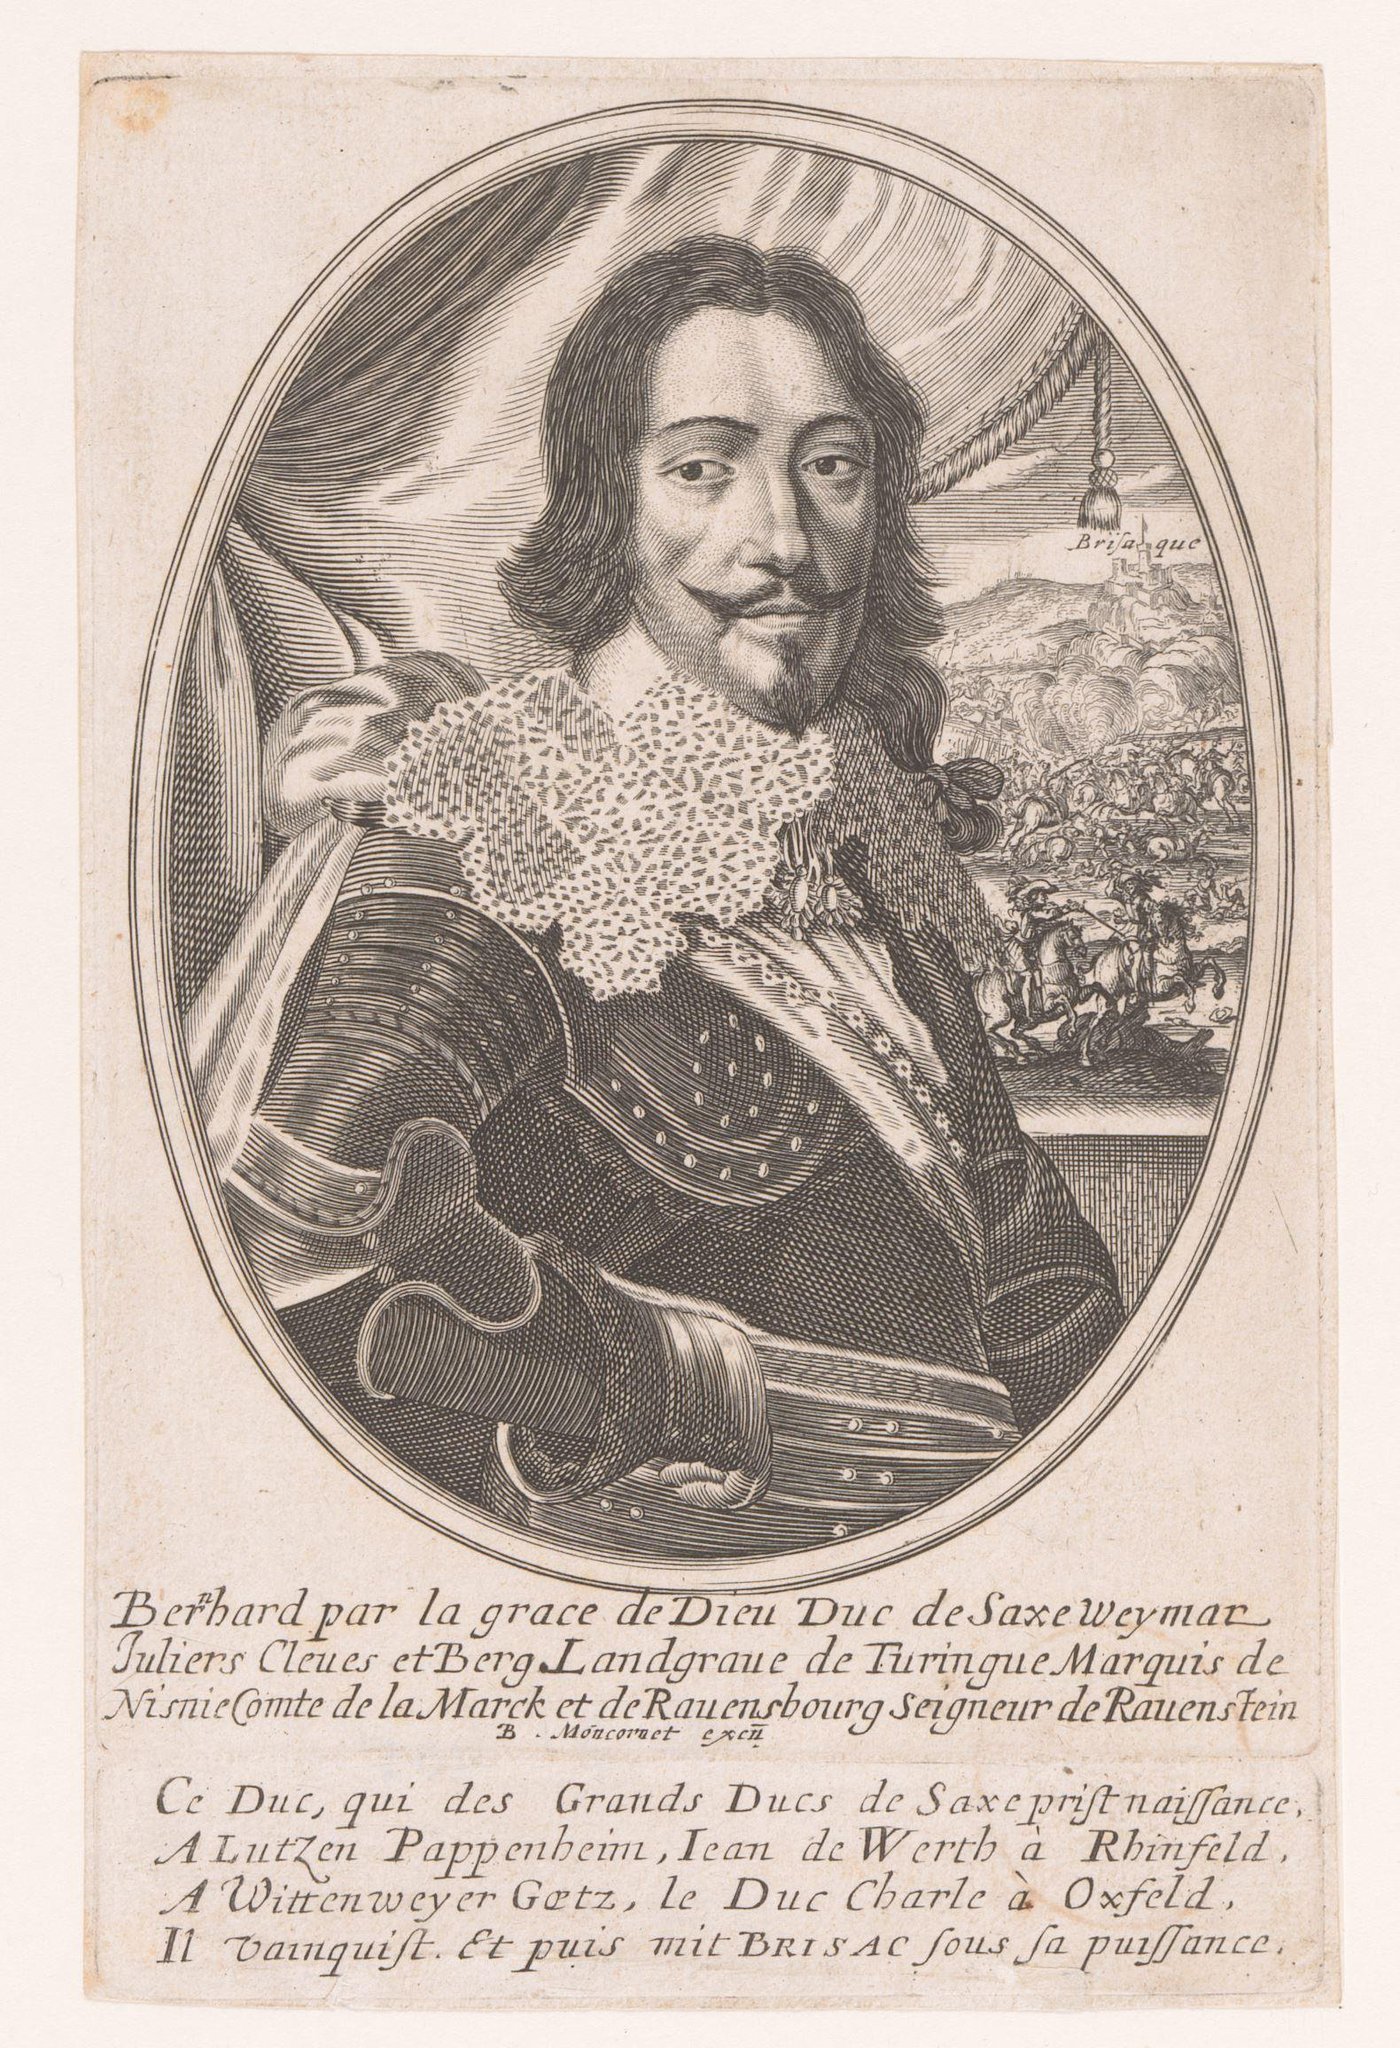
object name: print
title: Portret van Bernard van Saksen-Weimar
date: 1634-1668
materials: paper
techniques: engraving, etching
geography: paris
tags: historical persons, nobility and patriciate; chivalry, knighthood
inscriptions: collector's mark: Lugt 240